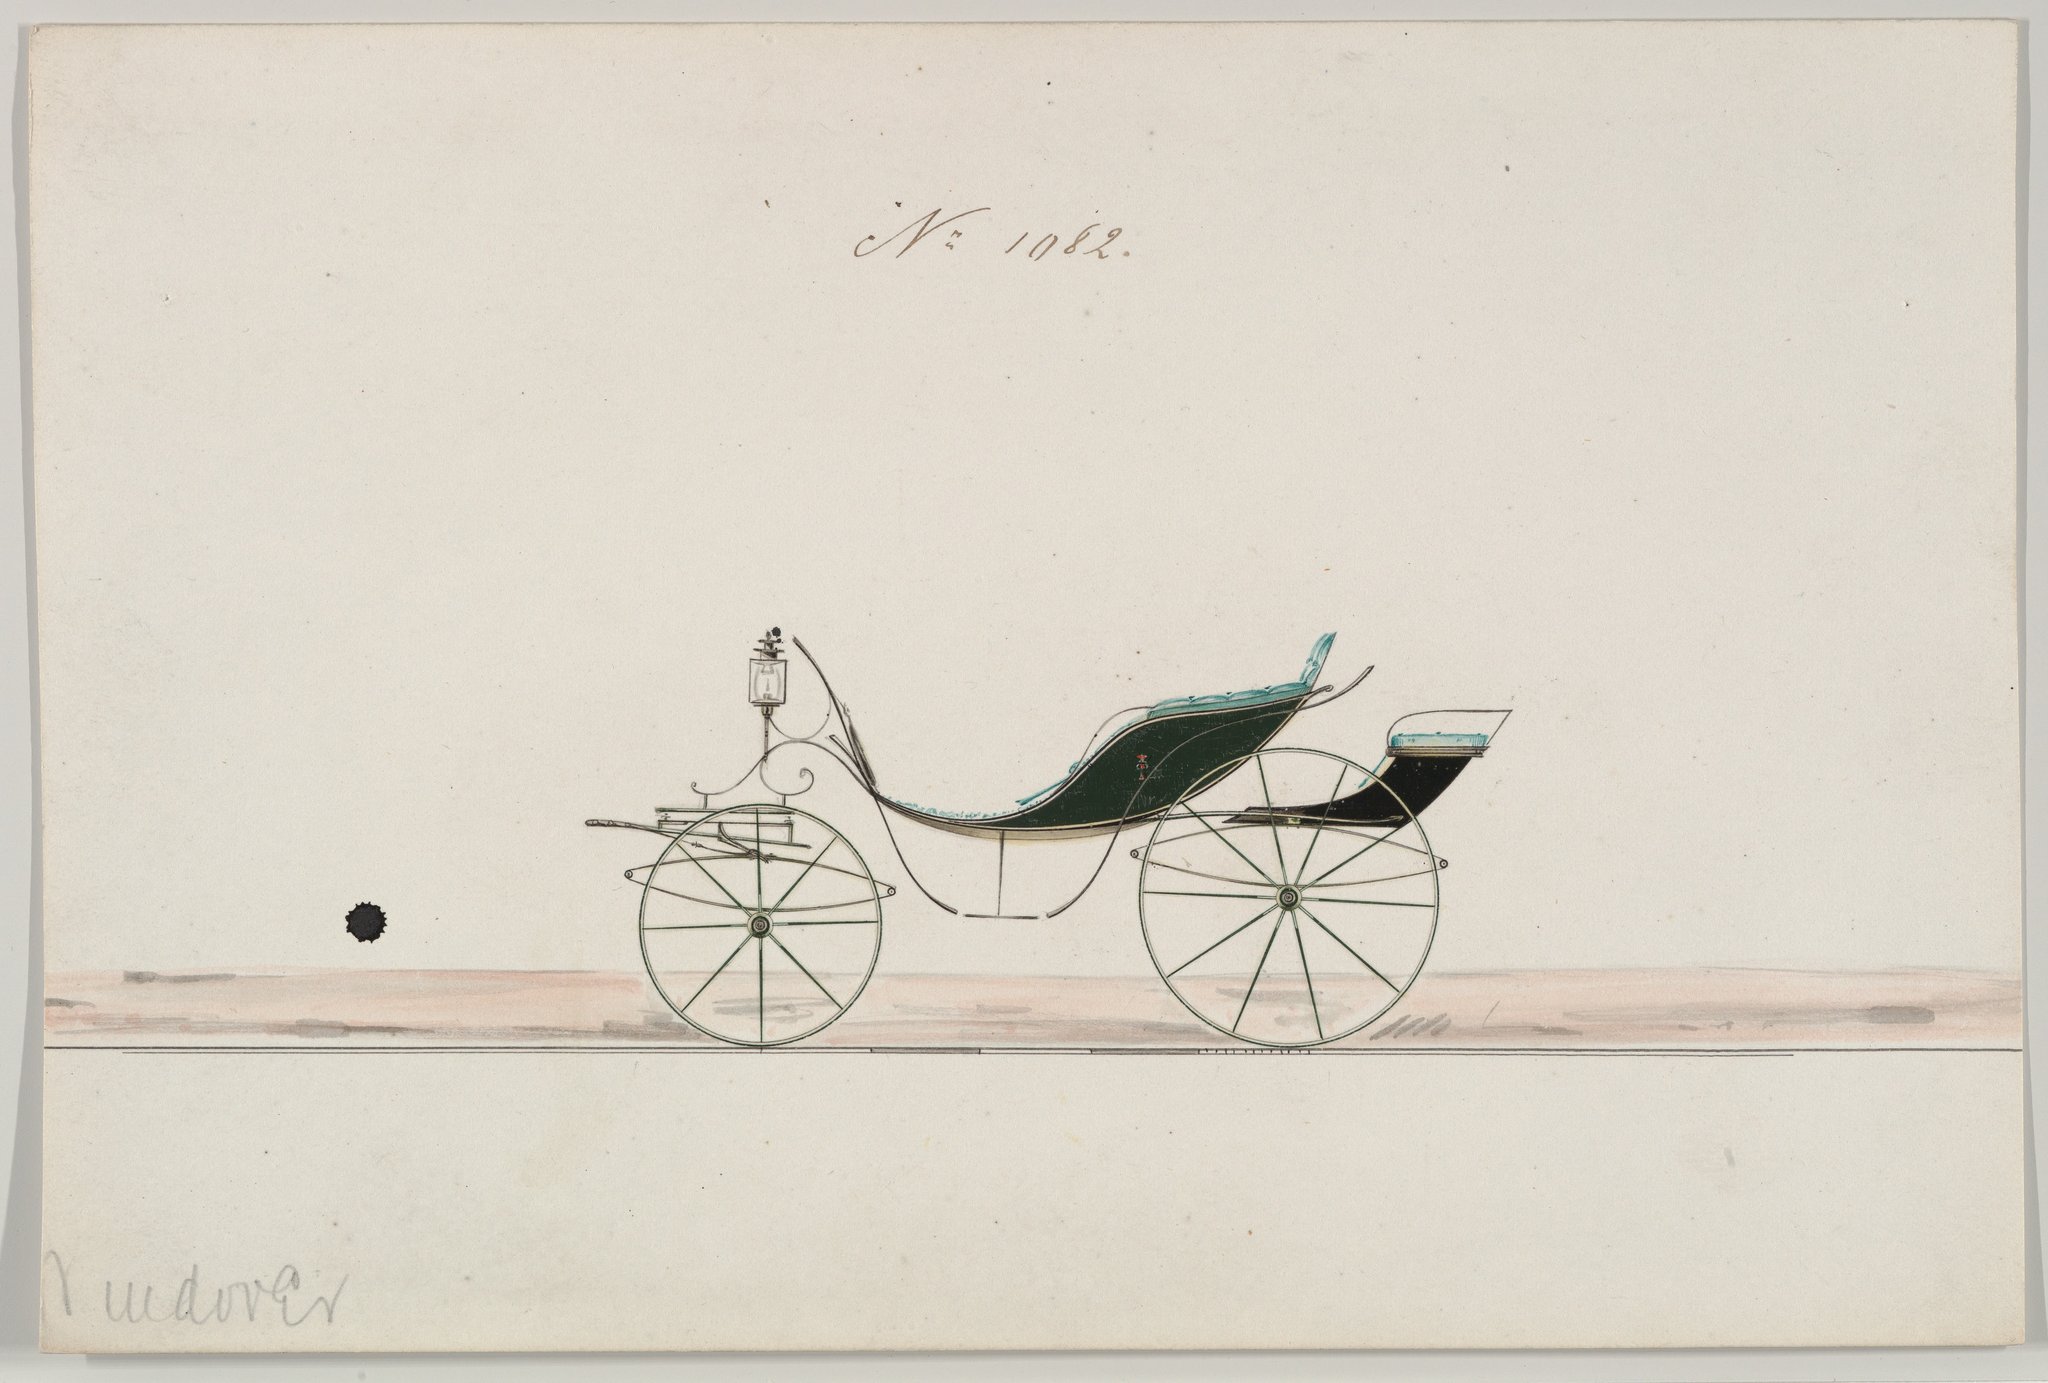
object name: drawing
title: Phaeton #1082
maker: brewster & co.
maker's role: manufacturer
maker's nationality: american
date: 1870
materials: gouache, gum arabic, ink, watercolor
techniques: pen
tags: carriages